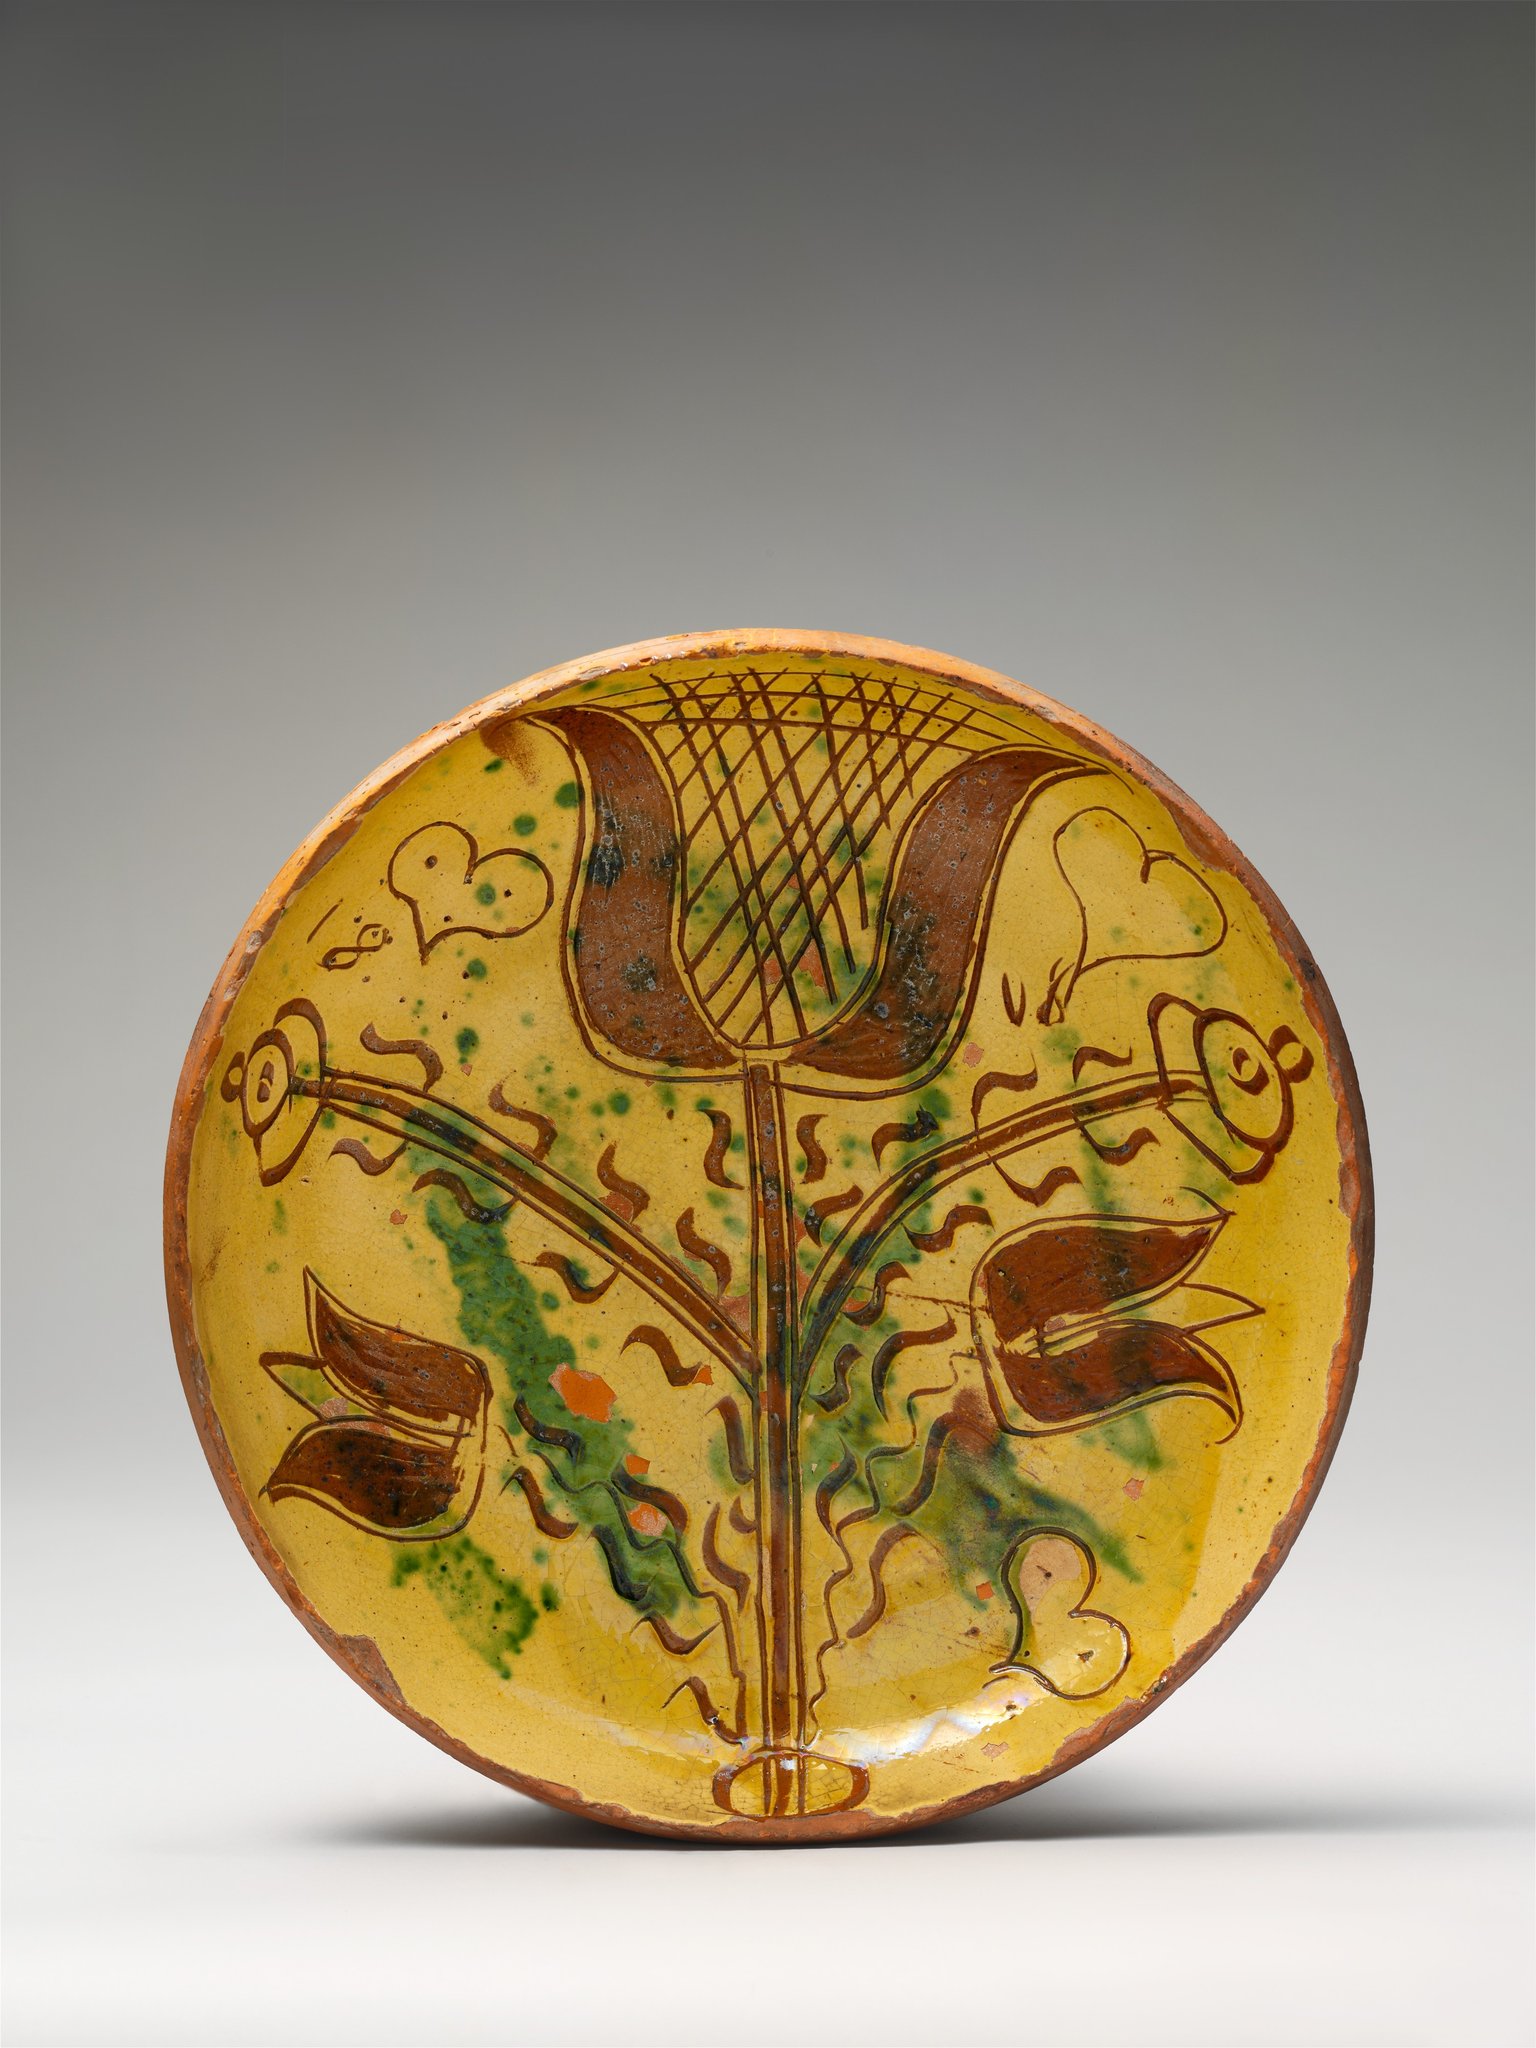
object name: plate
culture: american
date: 1808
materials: earthenware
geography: united states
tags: flowers